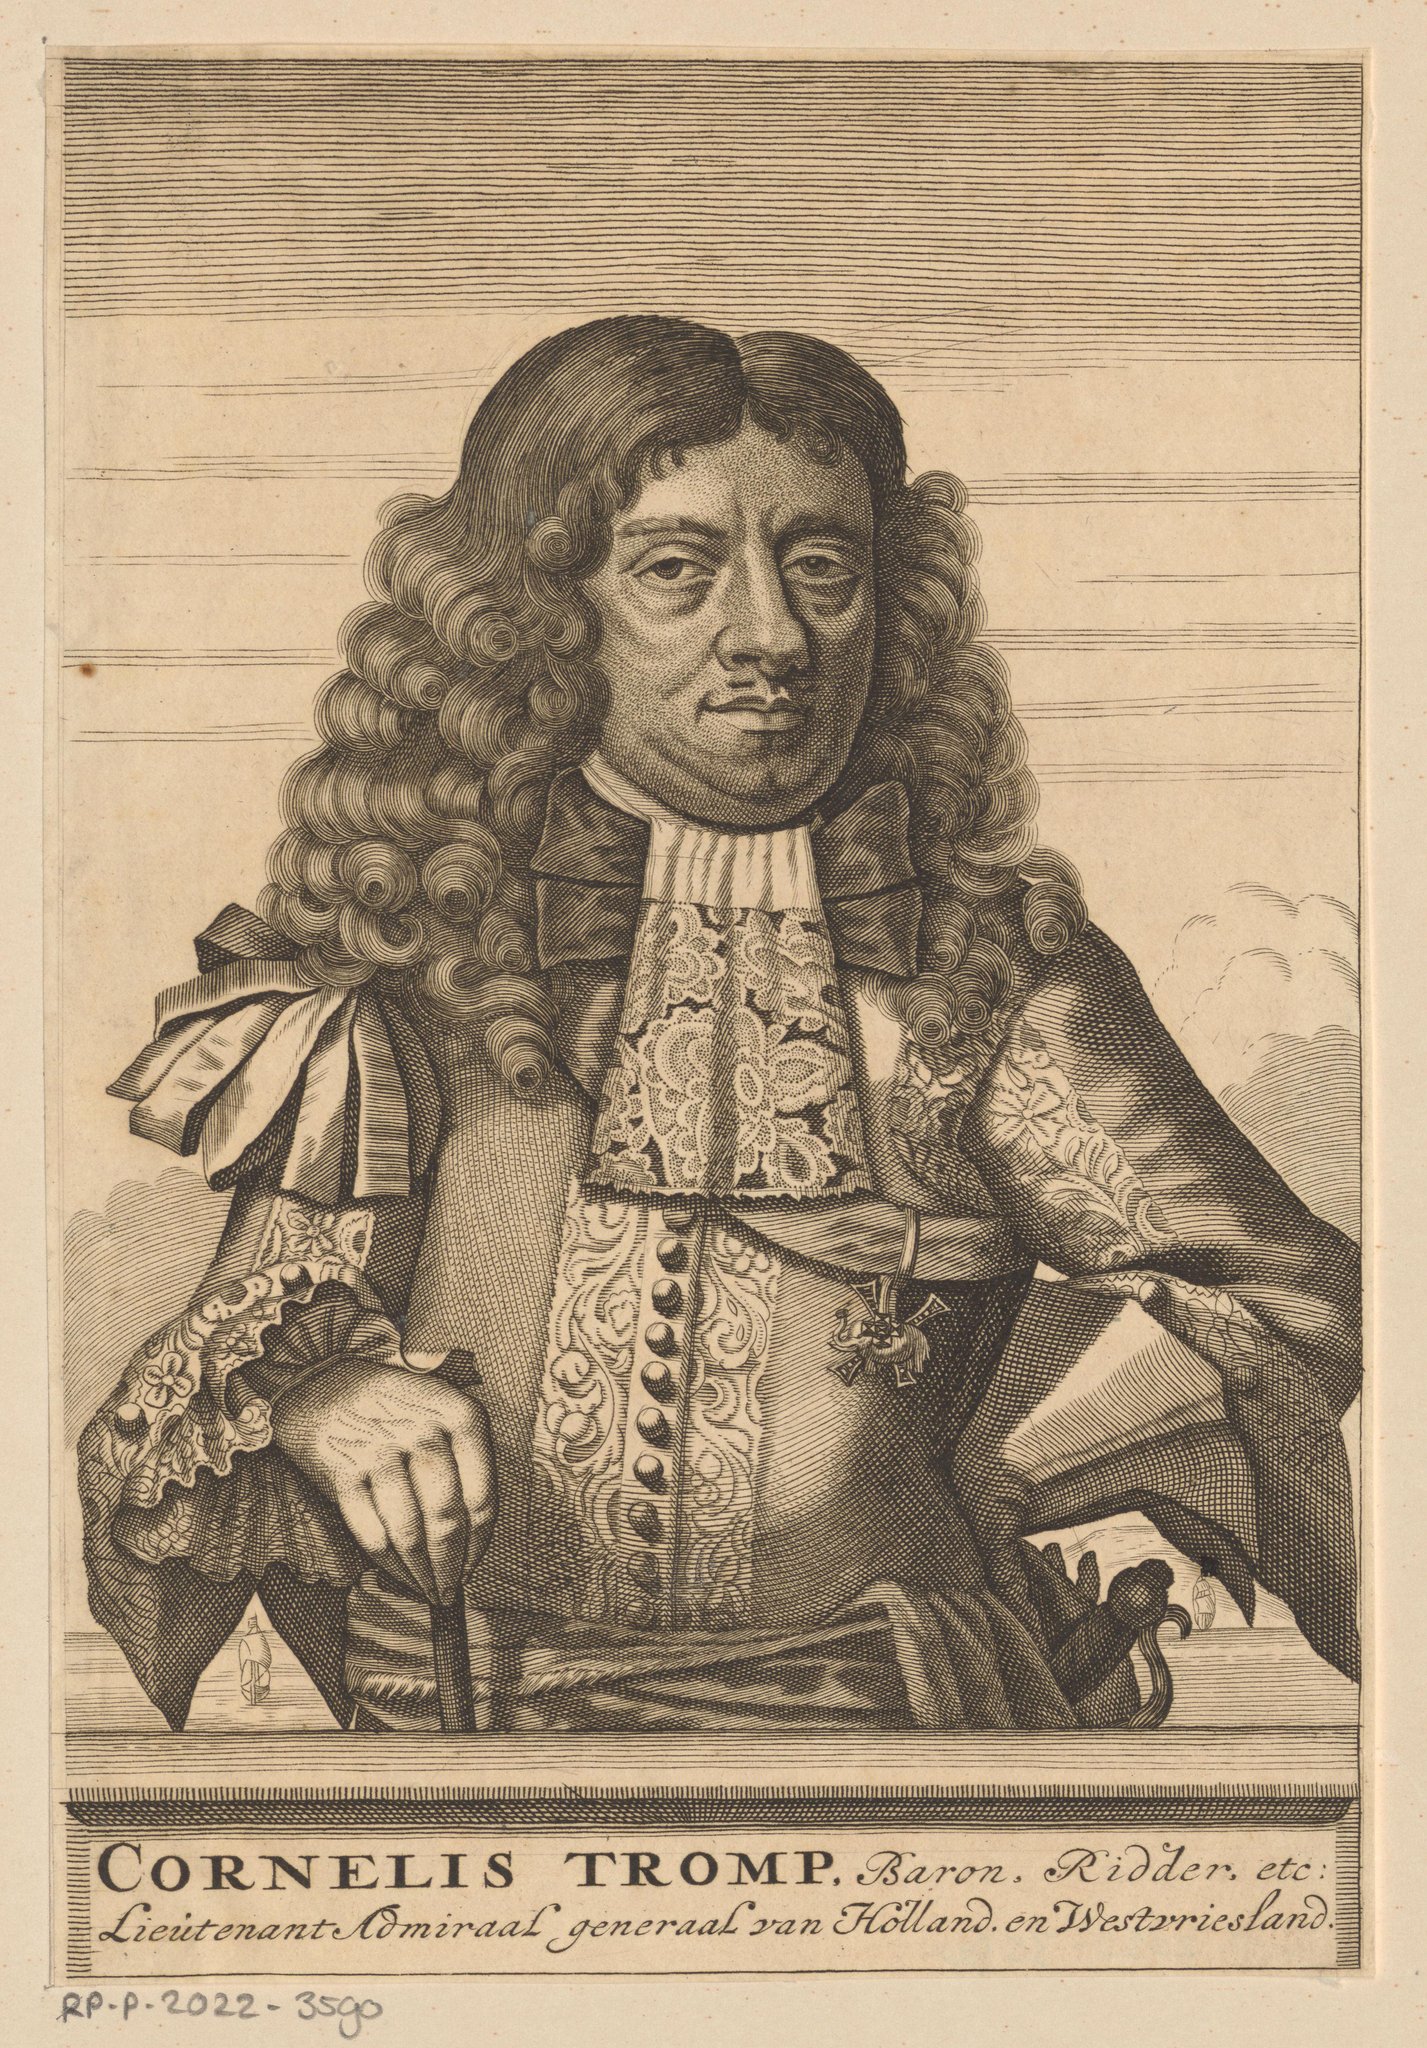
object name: print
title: Portret van Cornelis Tromp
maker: Anonymous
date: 1685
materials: paper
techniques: engraving, etching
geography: northern netherlands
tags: rotterdam, amsterdam, cornelis tromp, historical persons, commander-in-chief, admiral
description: Prent waarschijnlijk uit: Bos, Lambert van den. Historien onses tyds, behelzende saken van staat en oorlogh (...). Amsterdam: Jan Bouman I en Jan Claesz ten Hoorn, 1685, dl. 2, p. 338-339.